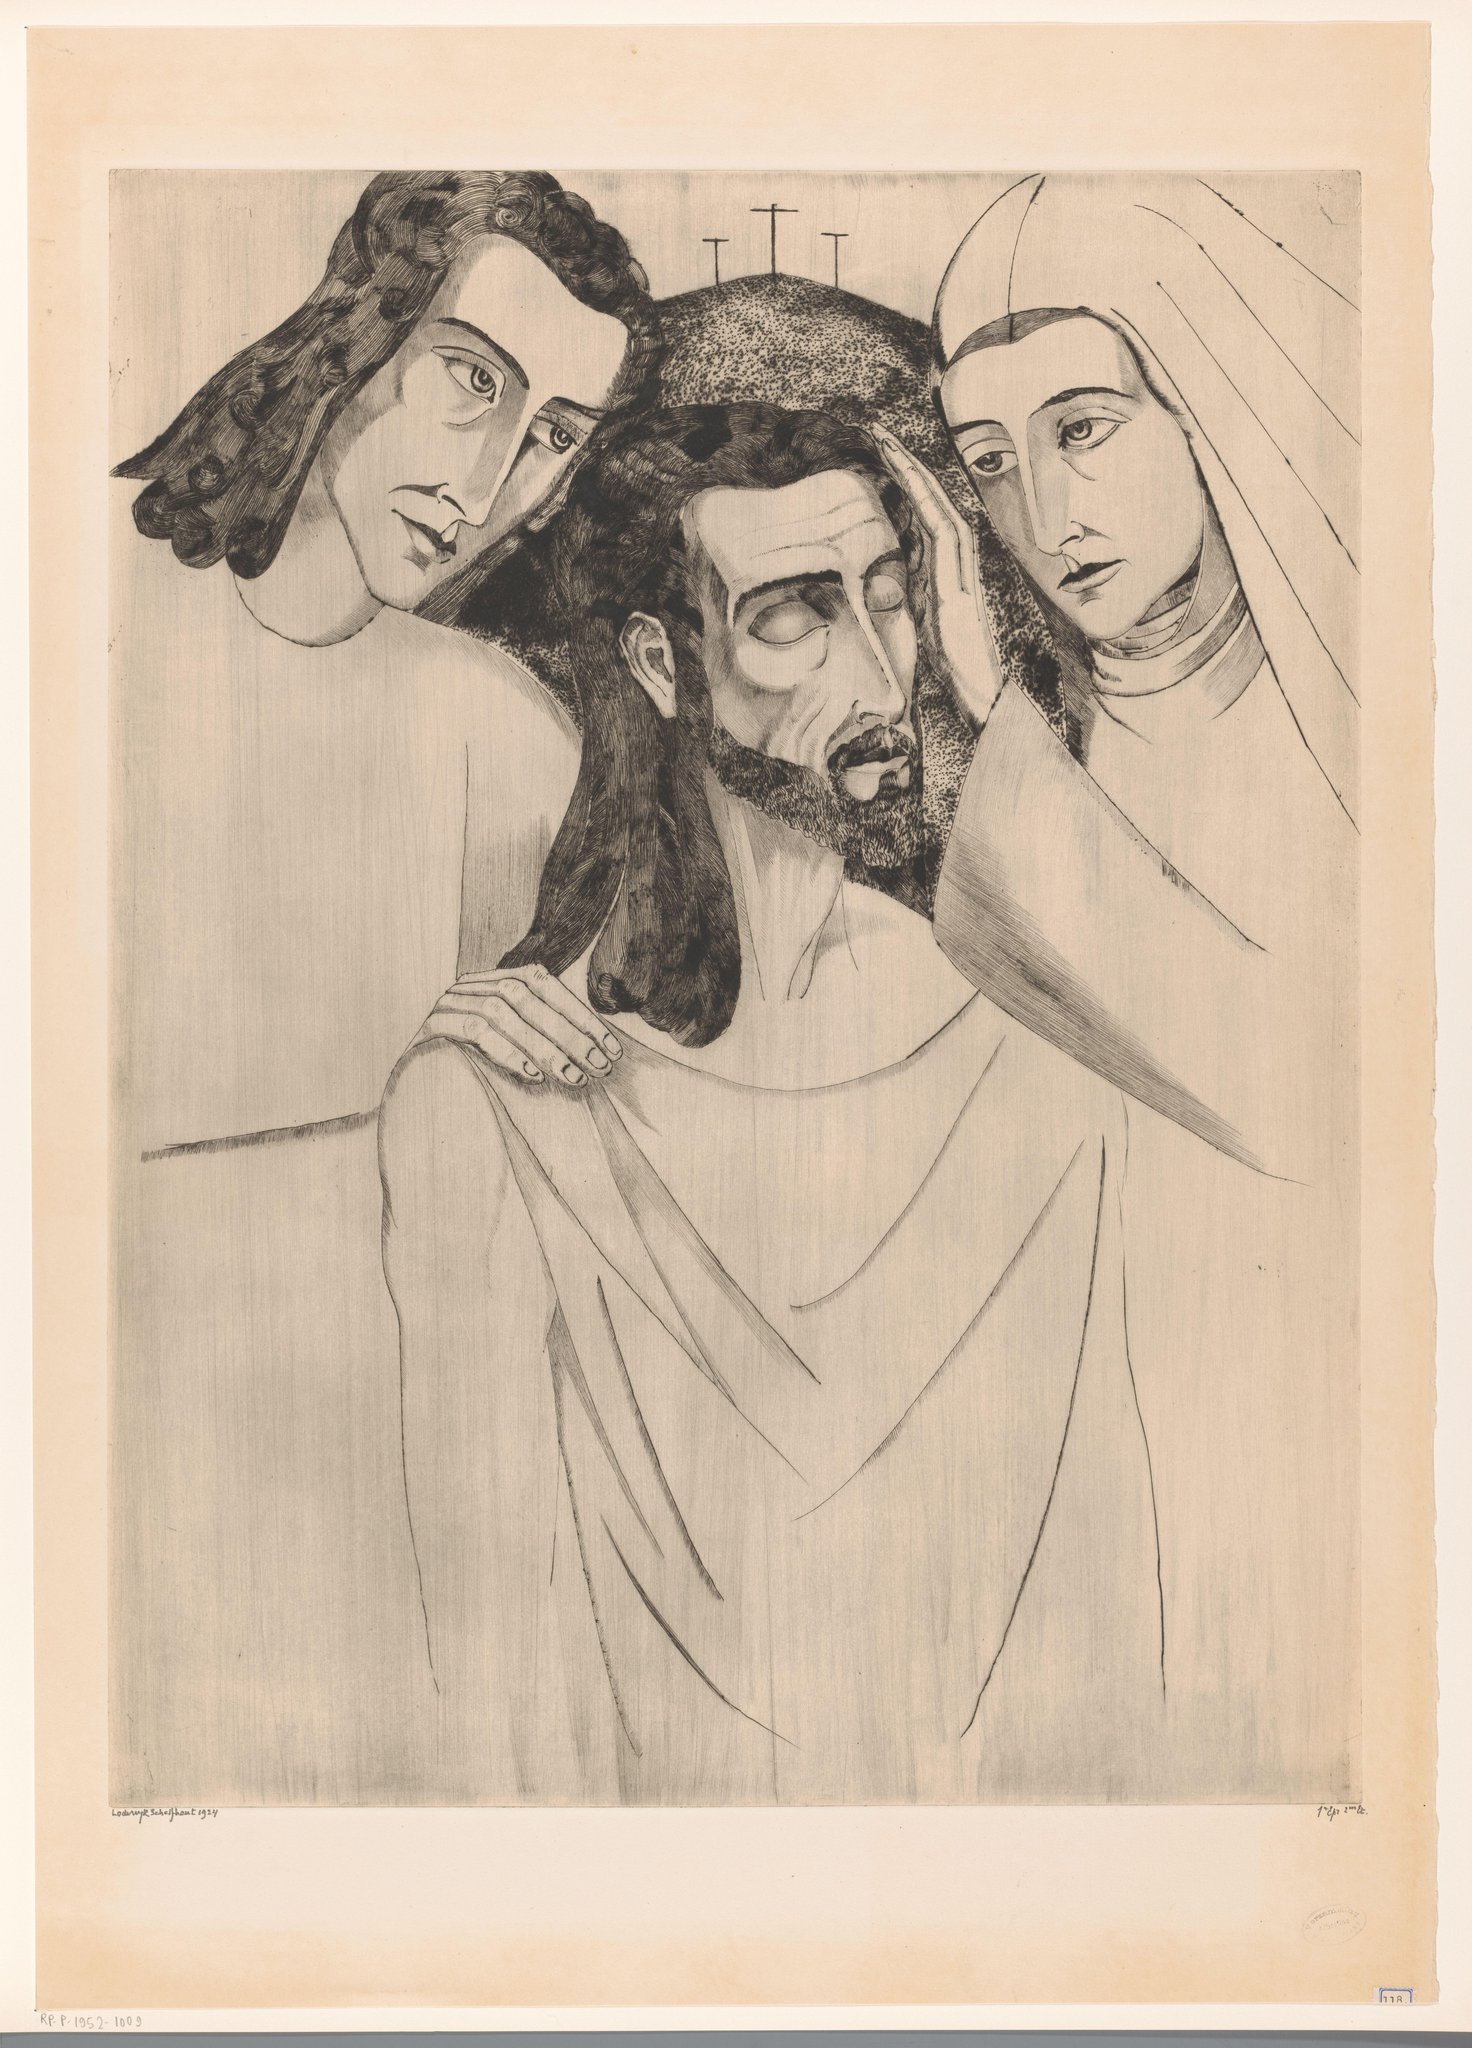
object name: print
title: Christus tussen Johannes de Doper en Maria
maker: lodewijk schelfhout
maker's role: draughtsman, print maker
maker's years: 1881-1943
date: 1924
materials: paper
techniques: drypoint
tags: adult christ together with others (non-narrative representations), the virgin mary, series of scenes from the life of john the baptist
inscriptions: collector's mark: Lugt 5i, collector's mark: Lugt 2228, collector's mark: Lugt 2760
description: Op de achtergrond de heuvel Golgota met de drie kruisen.